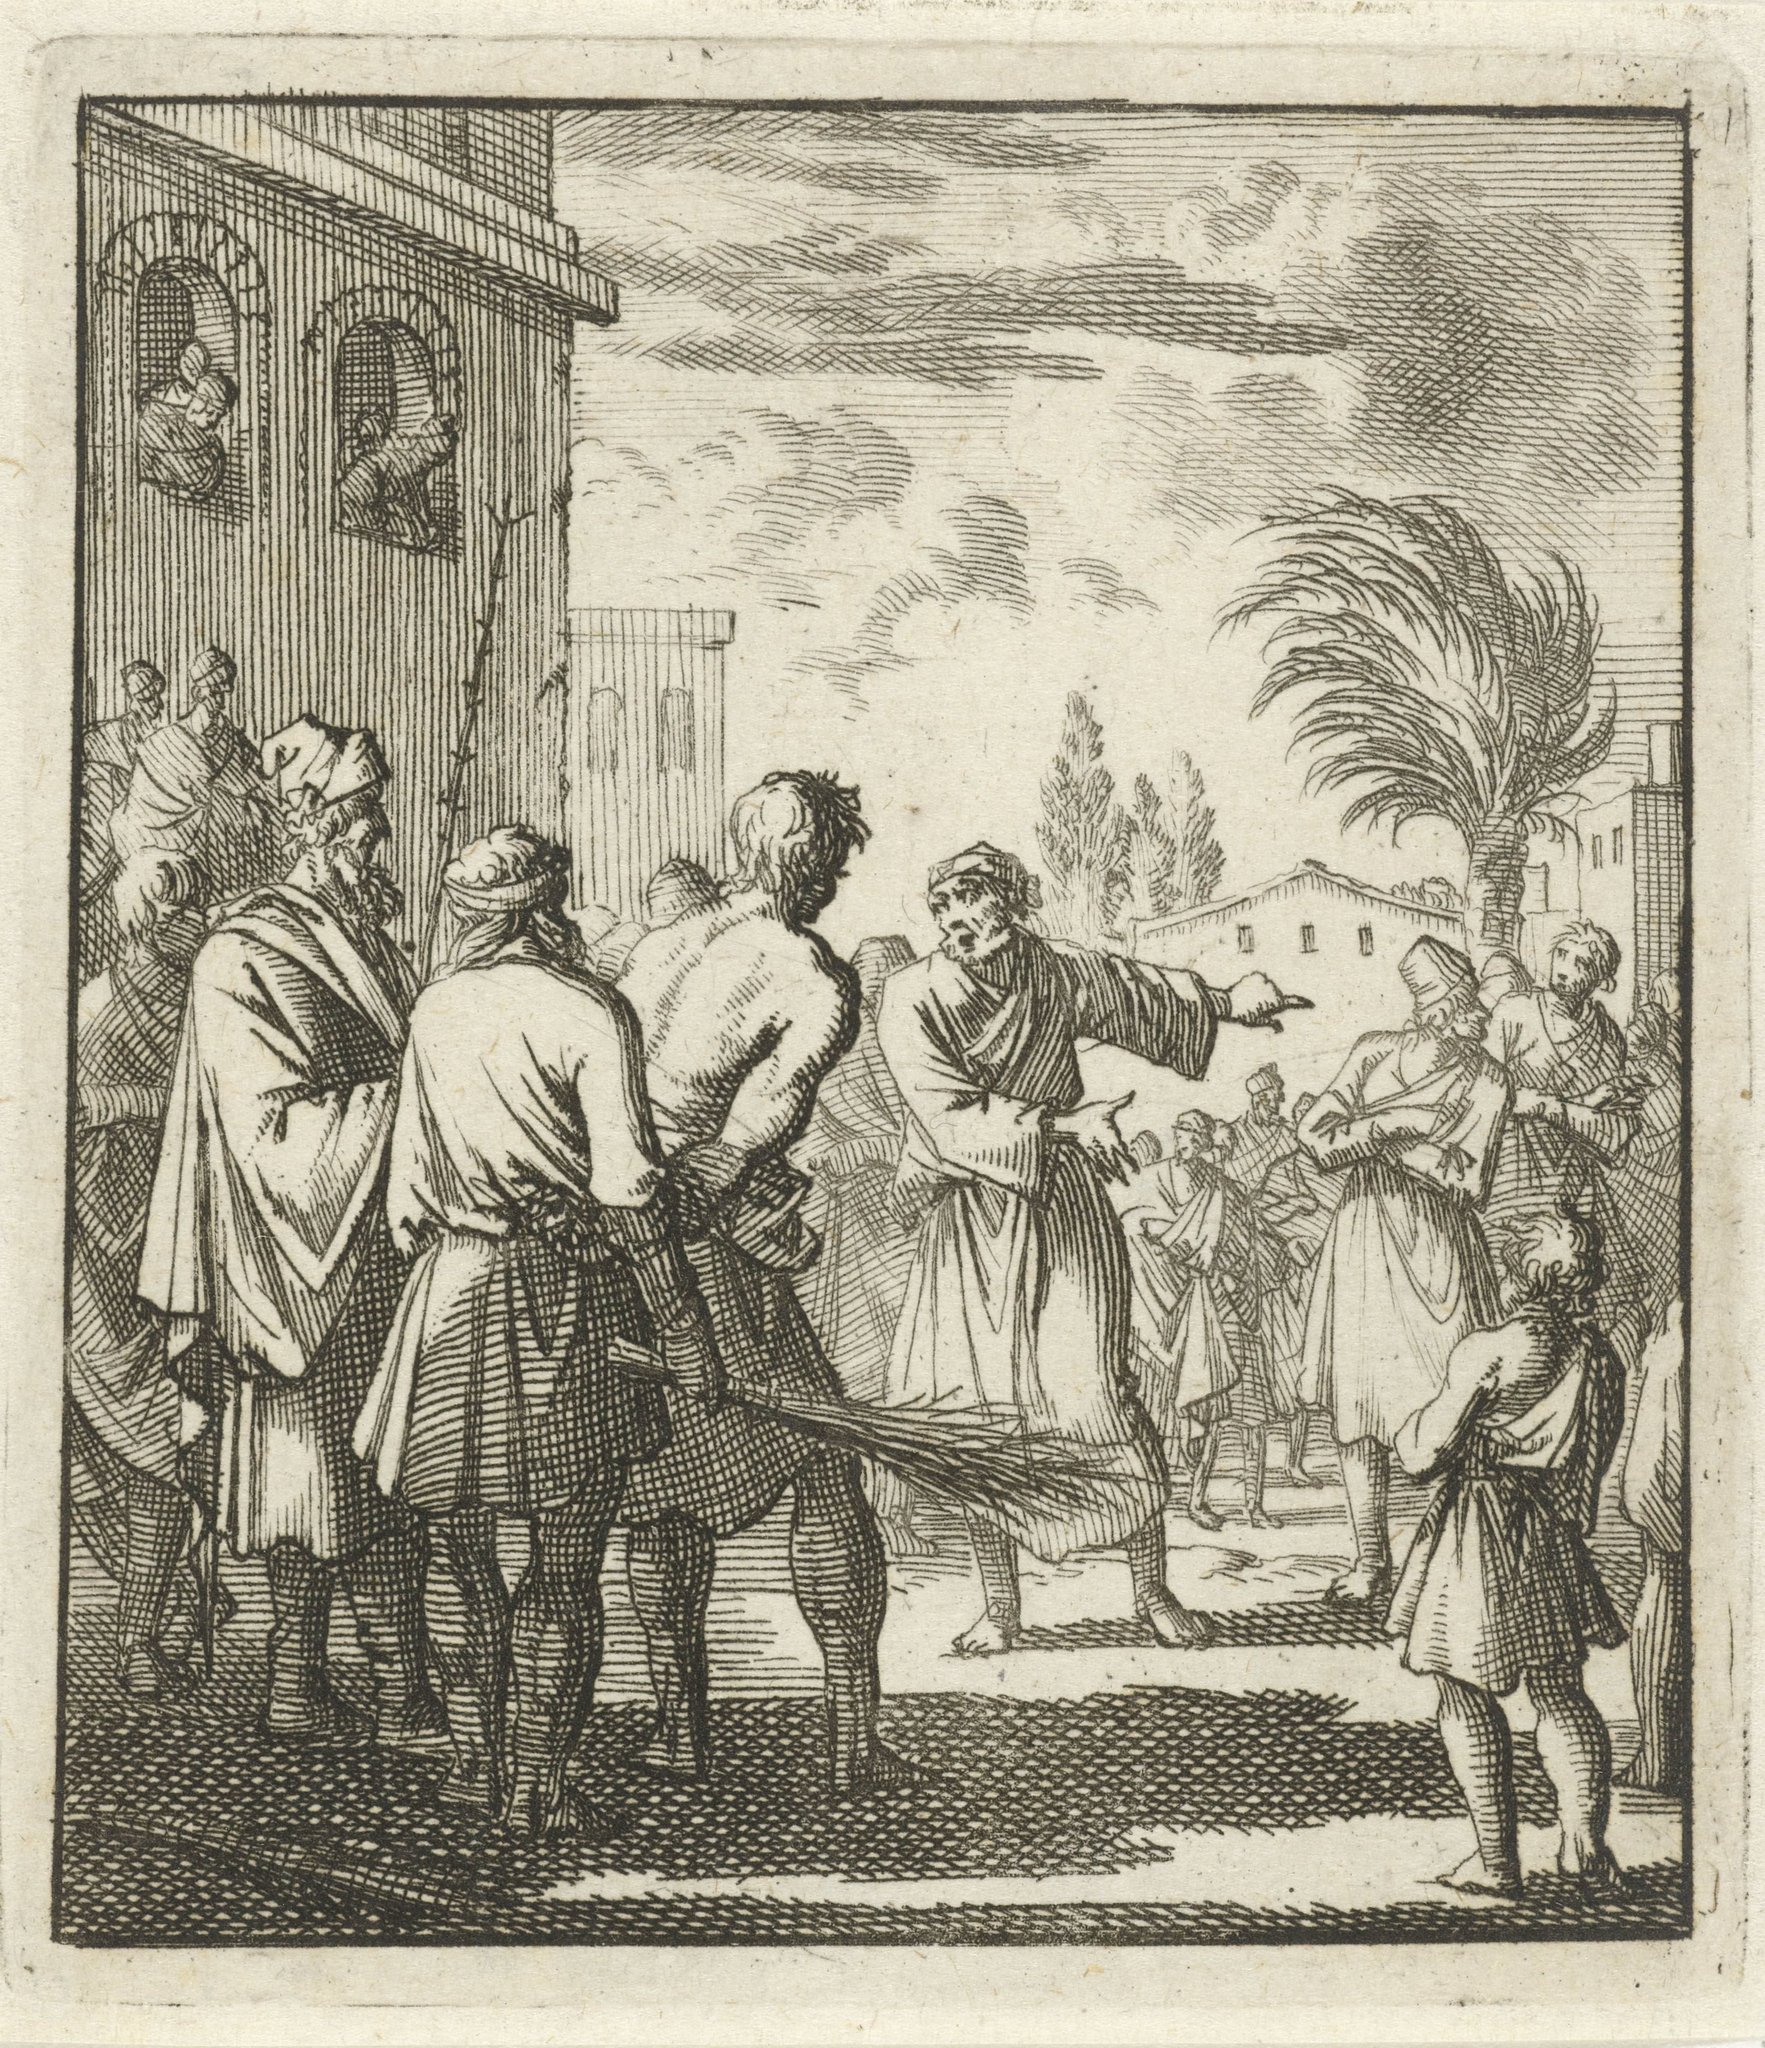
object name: print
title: Beul staat klaar om een gevangen barbier te geselen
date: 1693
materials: paper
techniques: etching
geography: amsterdam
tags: flogging, scourging (in public), robber, anchorite, hermit, executioner, hangman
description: Illustratie uit: Duĳkerius, Johannes. Voorbeeldzels der oude wyzen. Waar in (...) de menschelijke hartstogten (...) behandeld worden. Amsterdam: Aart Wolsgrein, 1693, p. 61.